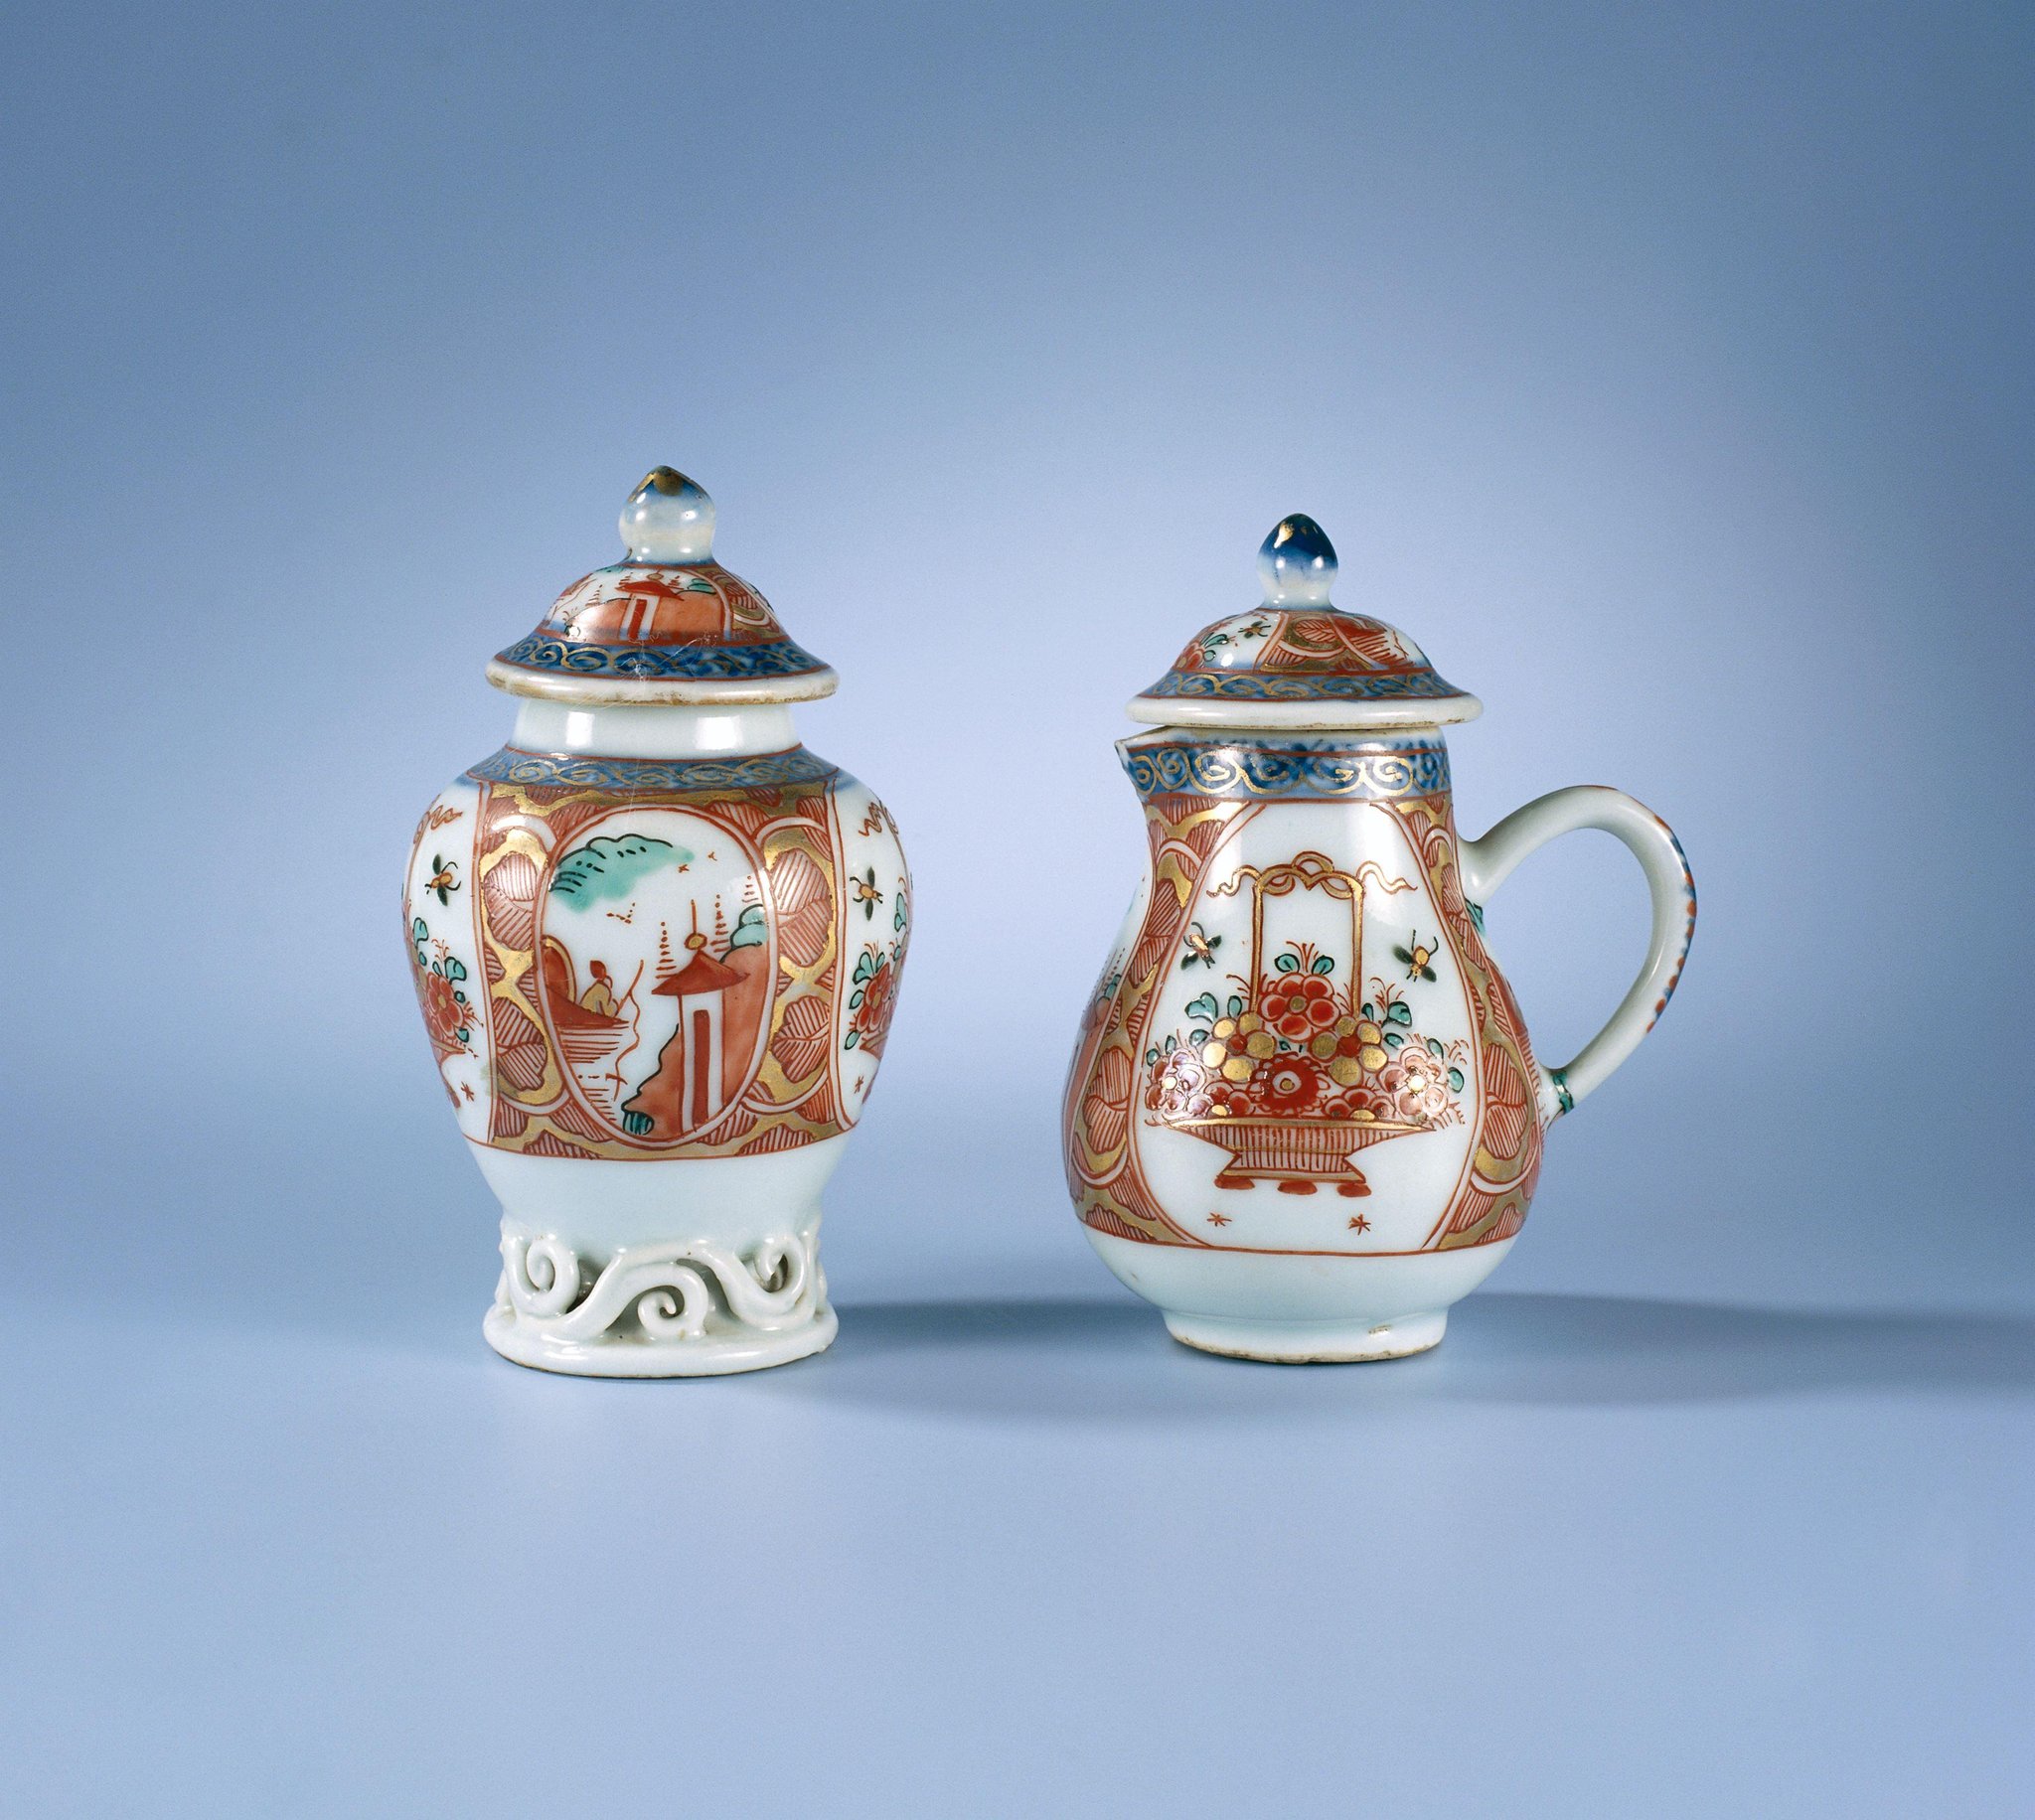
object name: milk jug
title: Milk jug with flower basket and water landscape in panels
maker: Anonymous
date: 1700-1799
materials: cobalt, glaze, gold, paint, porcelain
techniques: firing, gilding, turning, vitrification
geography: japan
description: Kleine melkkan van porselein met peervormig lichaam, driehoekig tuit uit de rand en c-vormig oor, beschilderd in onderglazuur blauw en op het glazuur rood, groen, zwart en goud. Op de rand van de kan een Japanse decoratieve band in onderglazuur blauw. In Nederland een decoratie toegevoegd in emailkleuren. Op de buik een brede decoratieve band met arceerwerk met daarin uitgespaard vier cartouches met afwisselend een rivierlandschap met een man in een boot en een bloemenmand met twee insecten; op de rand krulwerk. Overgedecoreerd (Amsterdams bont).